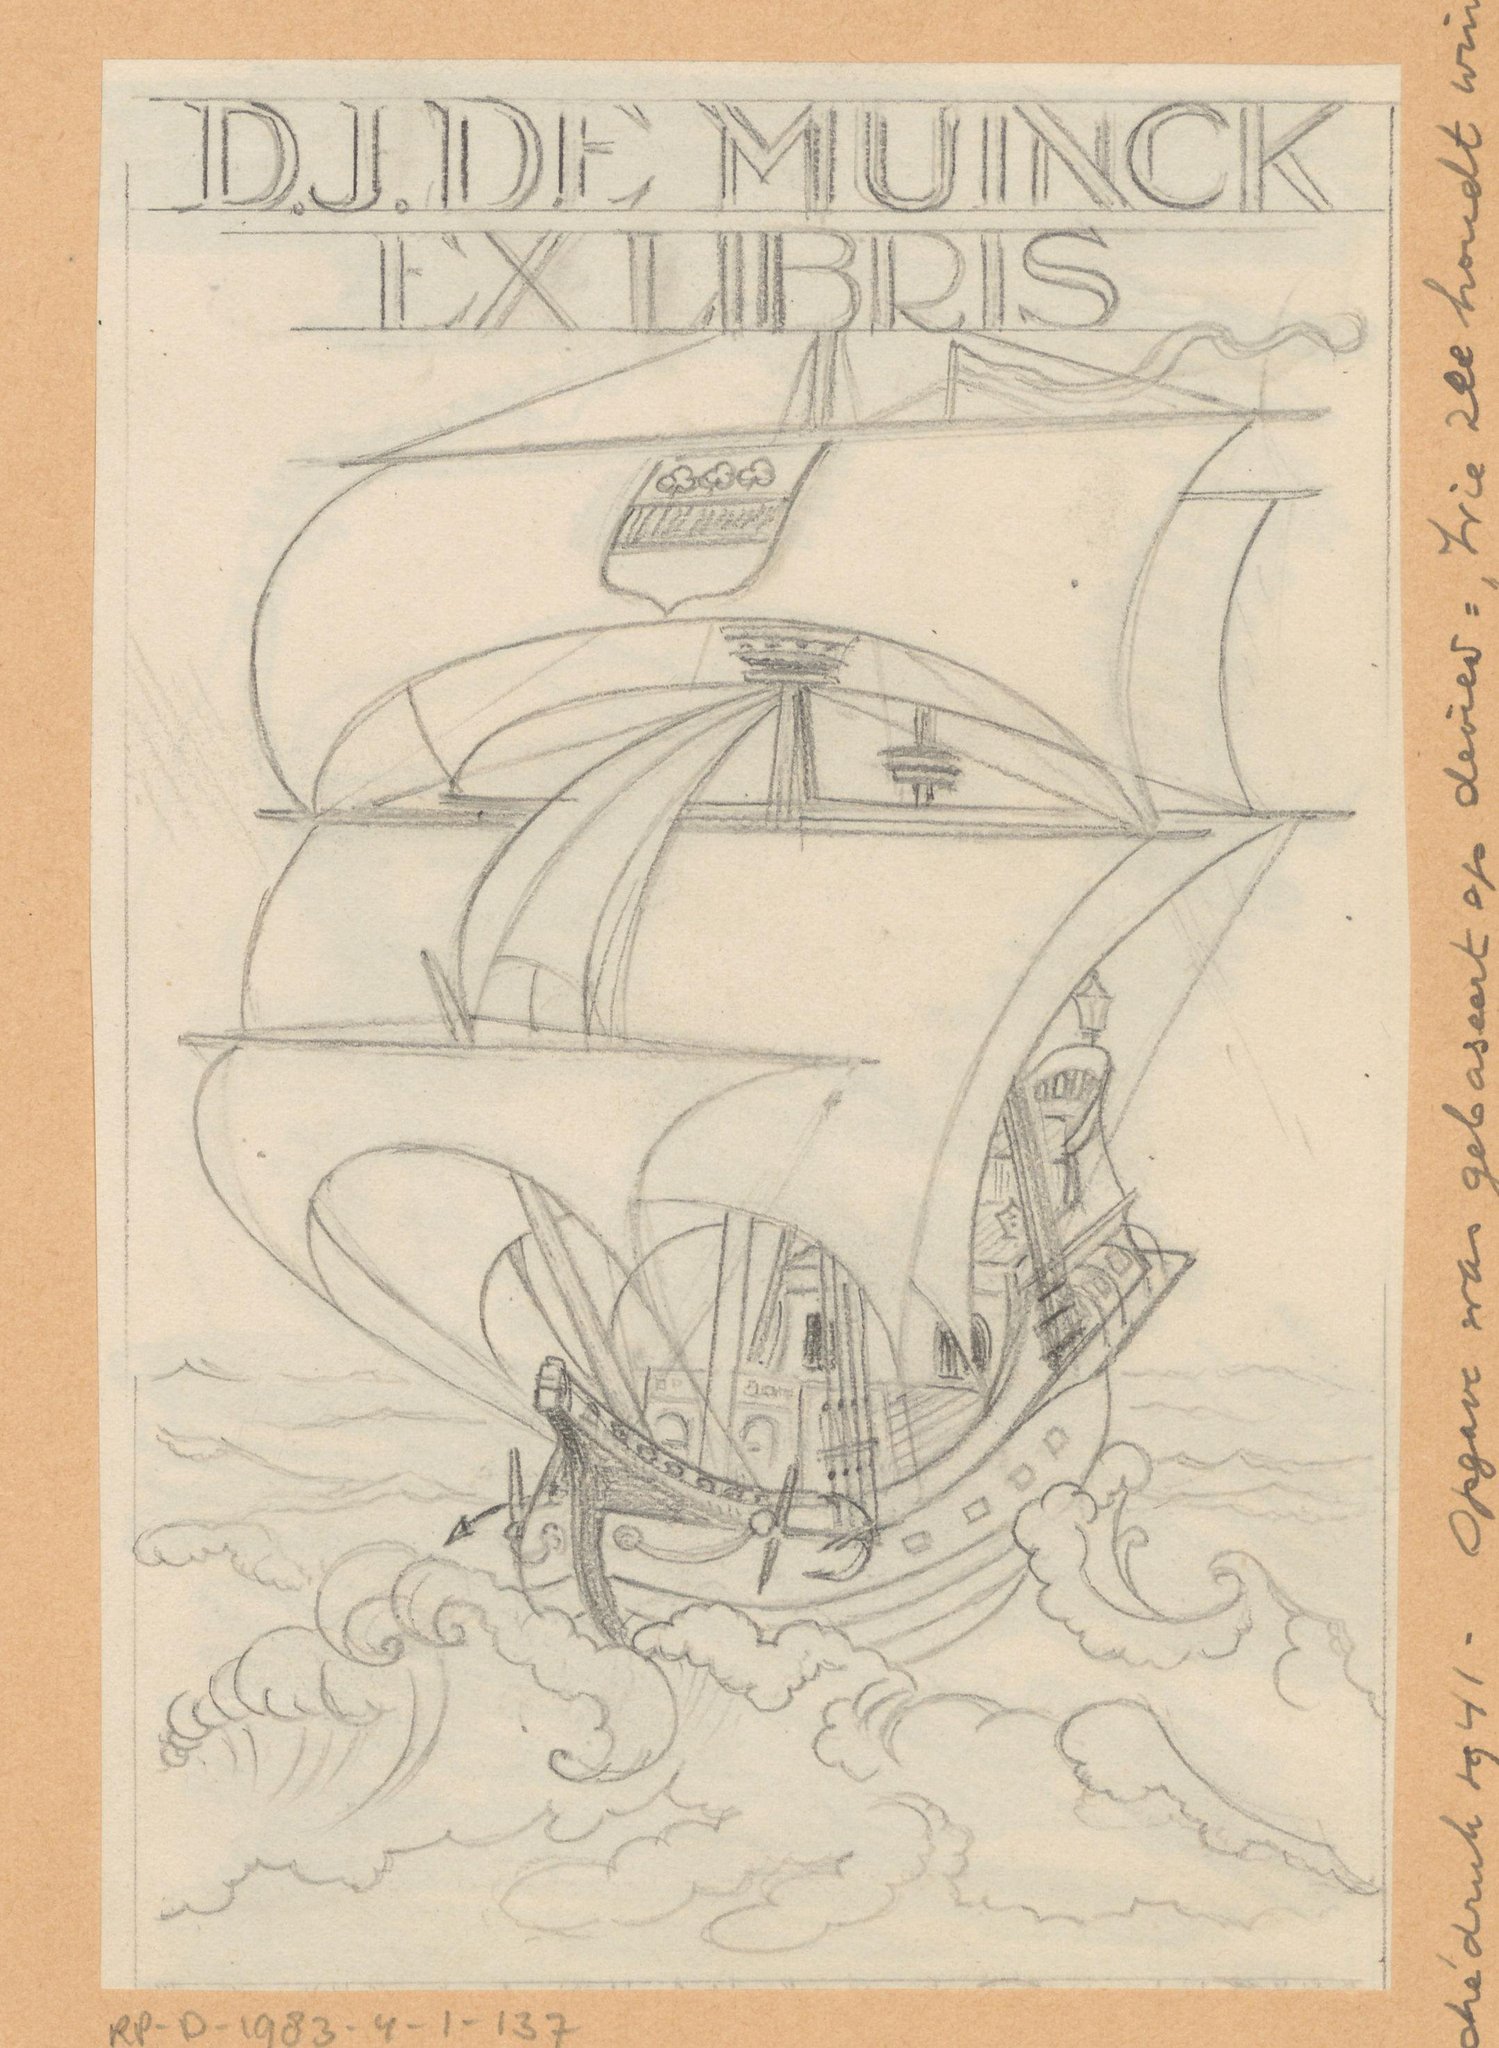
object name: bookplate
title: Ontwerptekening voor ex libris van D.J. de Muinck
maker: otto verhagen (i)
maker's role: draughtsman, print maker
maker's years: 1885-1951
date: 1941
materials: paper, pencil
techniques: drawing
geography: netherlands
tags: manufacturer, sailing-ship, sailing-boat, armorial bearing, heraldry, sea